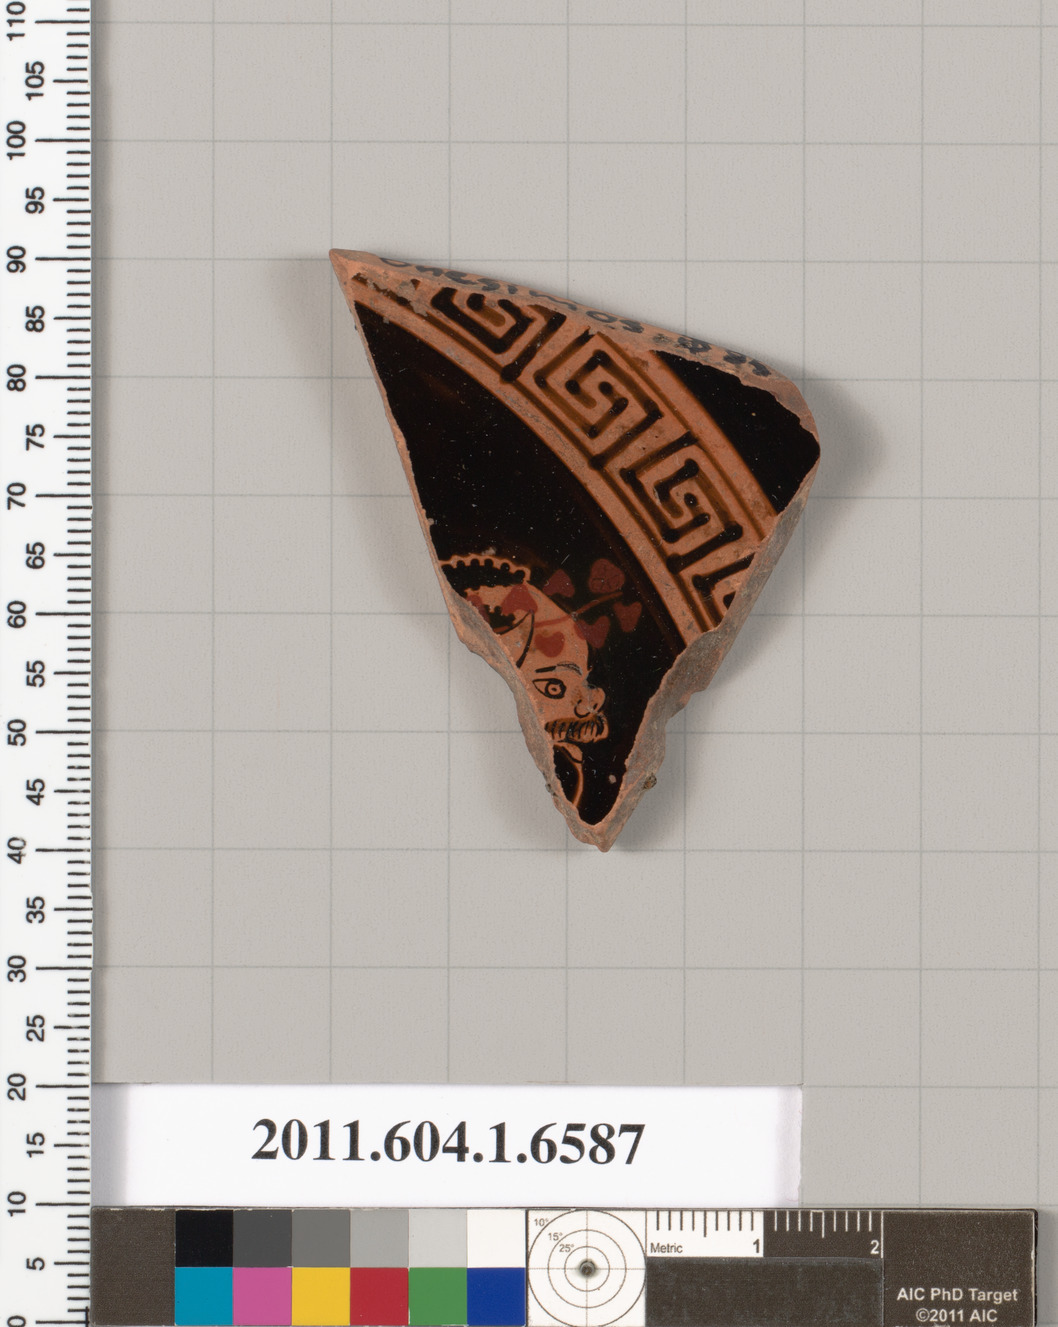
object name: kylix fragment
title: Terracotta fragment of a kylix (drinking cup)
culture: greek, attic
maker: onesimos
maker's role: artist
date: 490-480 BCE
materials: terracotta